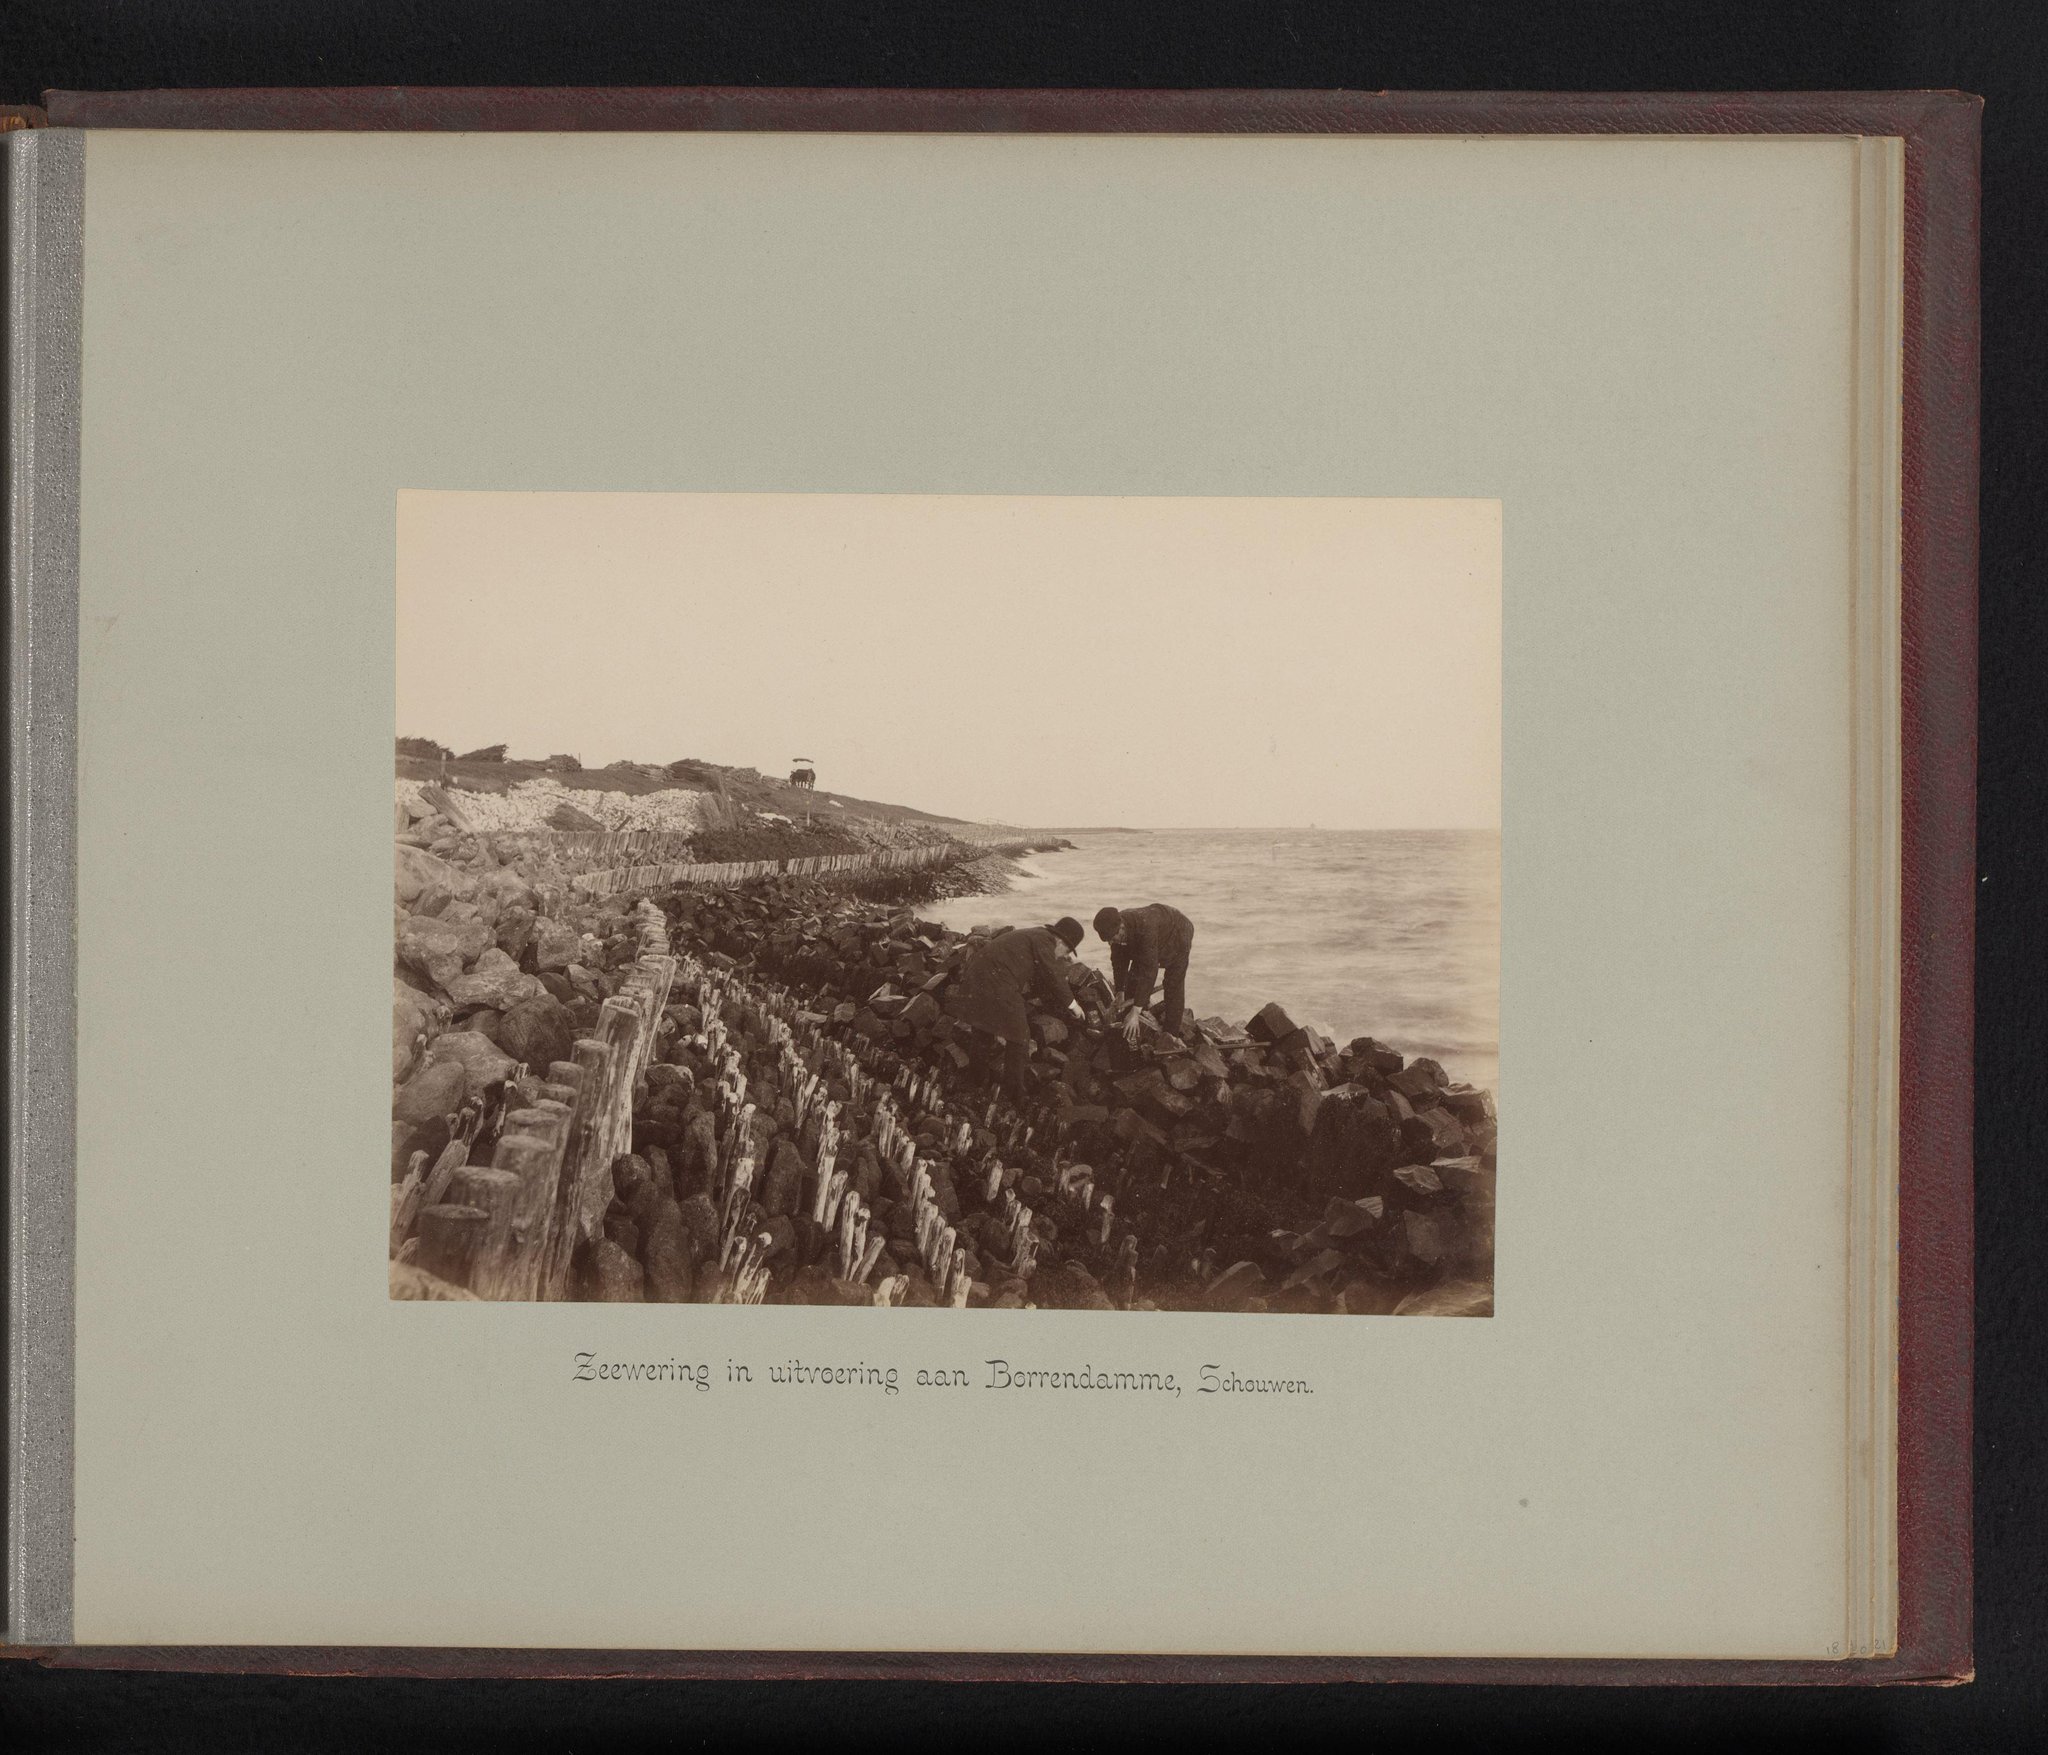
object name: album leaf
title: Twee mannen leggen zeewering aan bij Borrendamme op Schouwen-Duiveland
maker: carl emil mögle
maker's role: fotograaf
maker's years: 1857-1934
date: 1883-1900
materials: cardboard, photographic support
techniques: albumen print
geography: schouwen-duiveland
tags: adult man (+ two persons), dikes, levee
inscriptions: inscription: ‘C. E. MÖGLE/ PHOTOGRAAF/ ROTTERDAM’